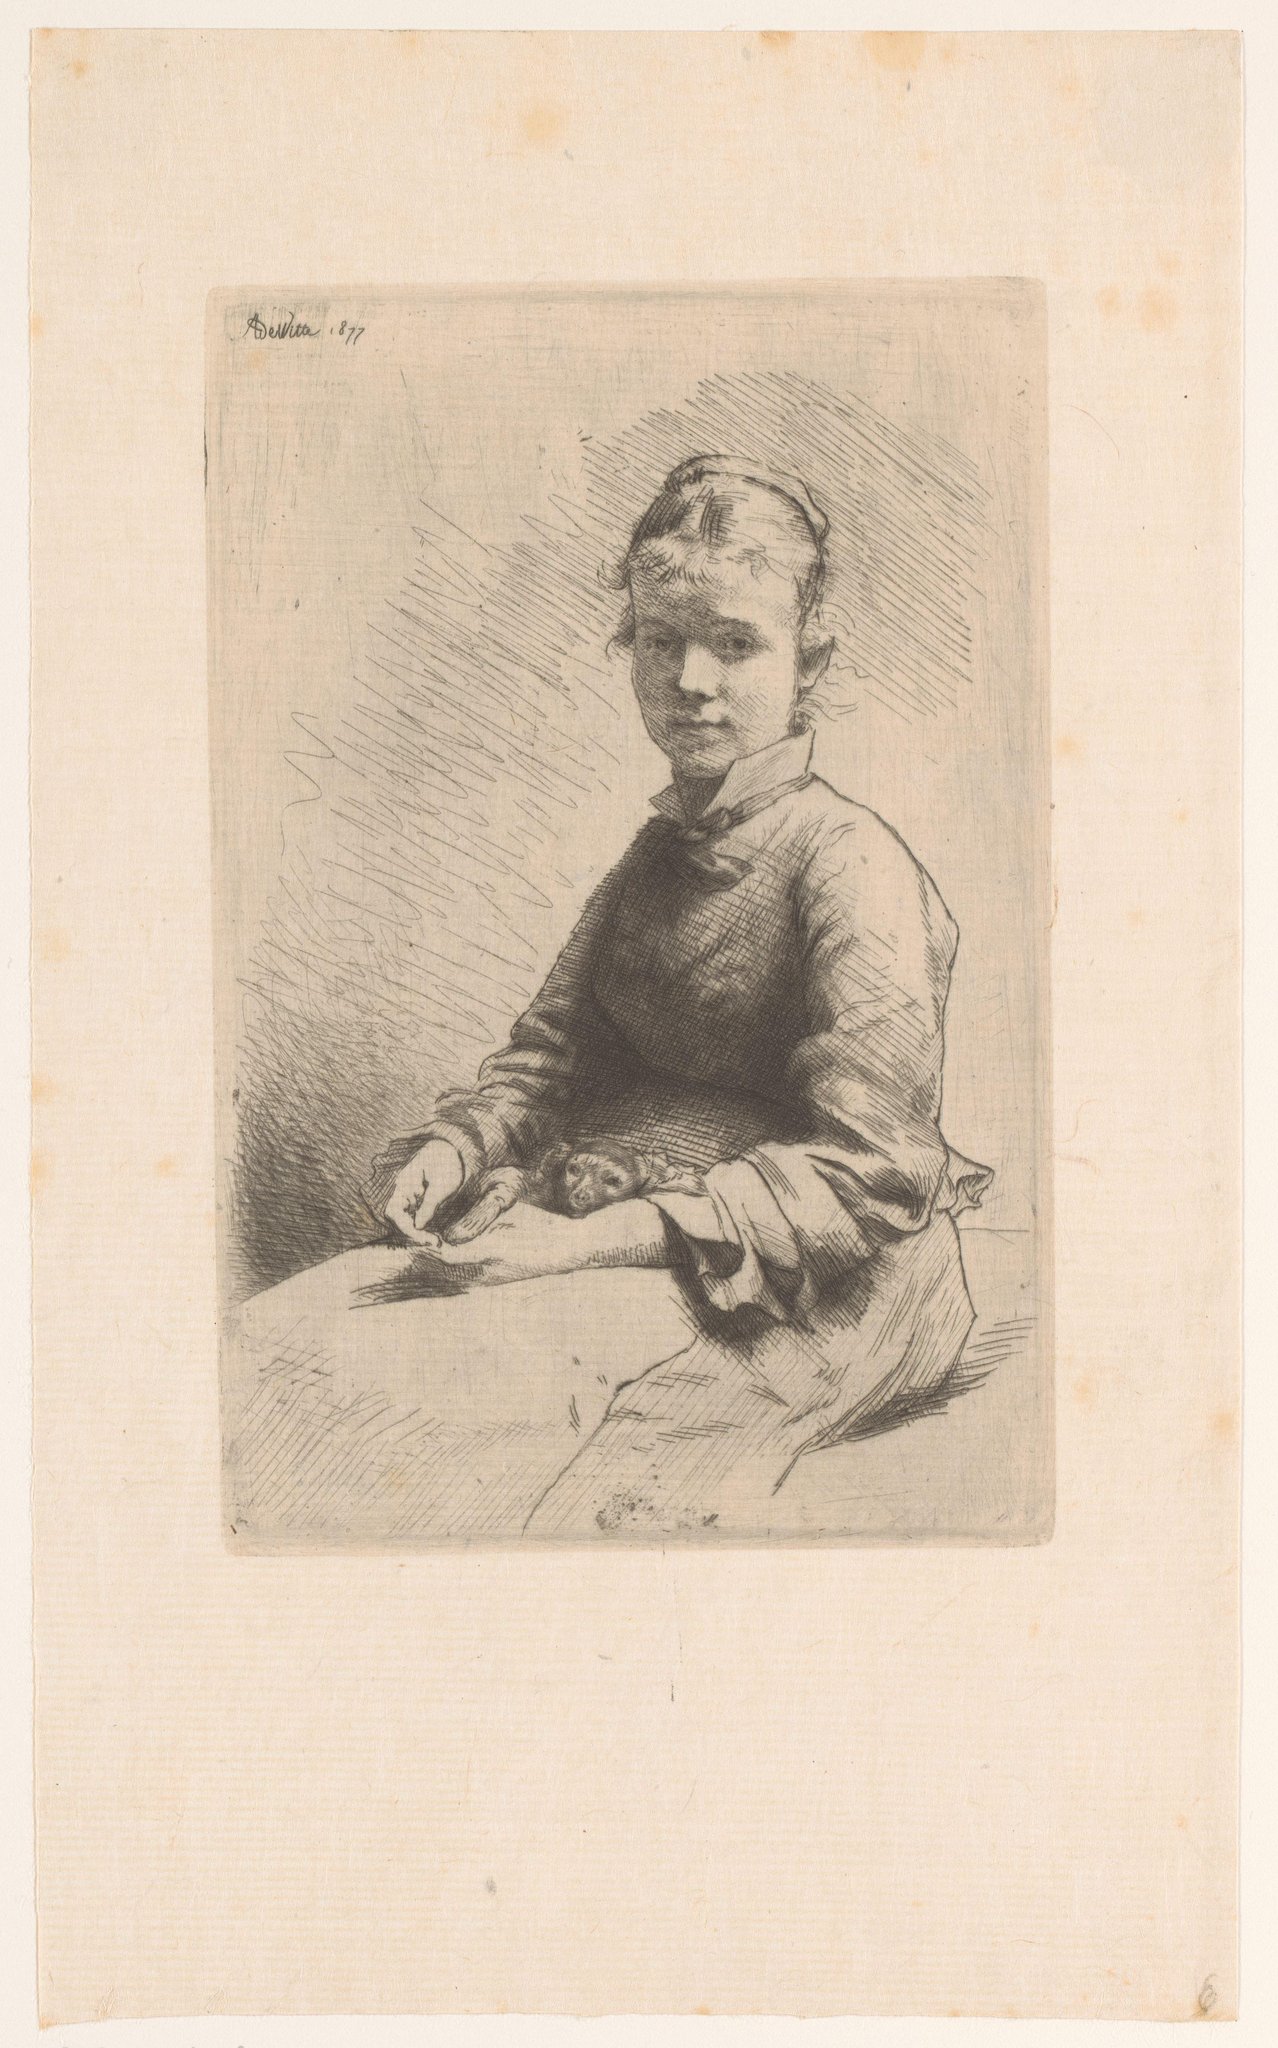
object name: print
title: Portret van een onbekende jonge vrouw met hond op schoot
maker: adrien de witte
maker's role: print maker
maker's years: 1850-1935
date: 1877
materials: paper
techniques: etching, intaglio, retroussage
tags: adolescent, young woman, maiden, sitting figure - aa - female human figure, historical persons, dog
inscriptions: collector's mark: Lugt 2228